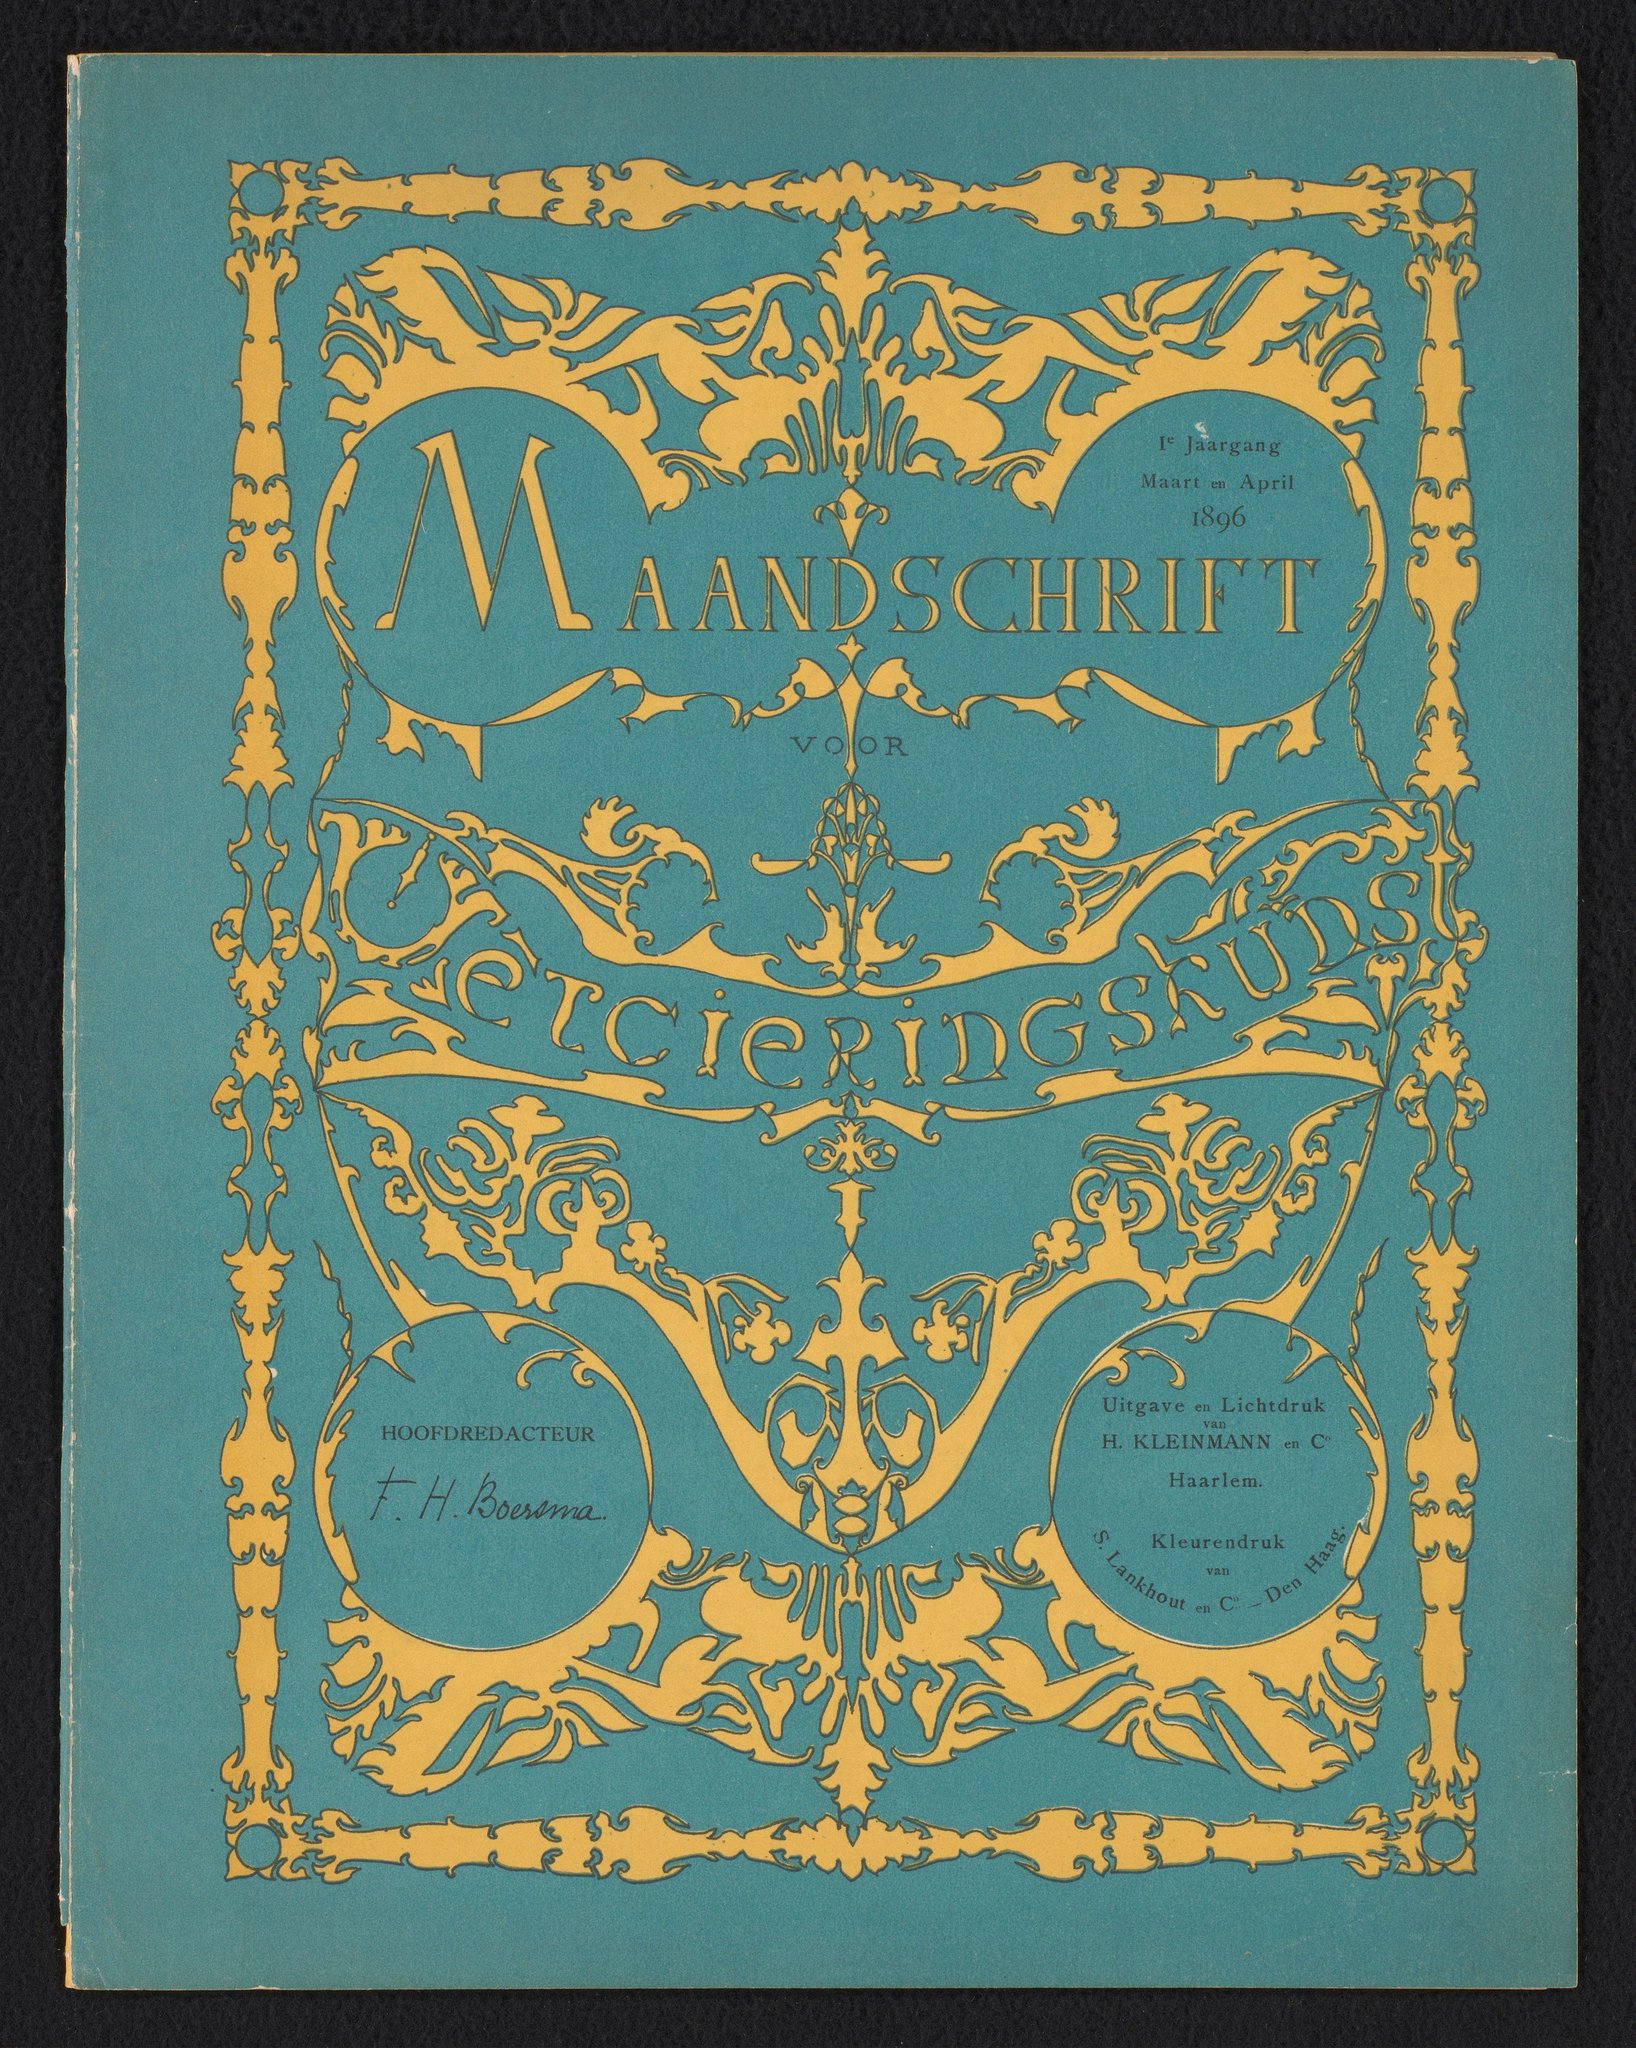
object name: wrapper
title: Omslag voor: Maandschrift voor vercieringskunst, 1896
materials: paper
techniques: lithograph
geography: haarlem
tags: weekly, monthly, magazine, etc., book-cover, binding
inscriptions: collector's mark: Lugt 2166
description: Dit omslag bevat een tweede (binnen)omslag, zeven reproducties (incompleet), en een advertentie.